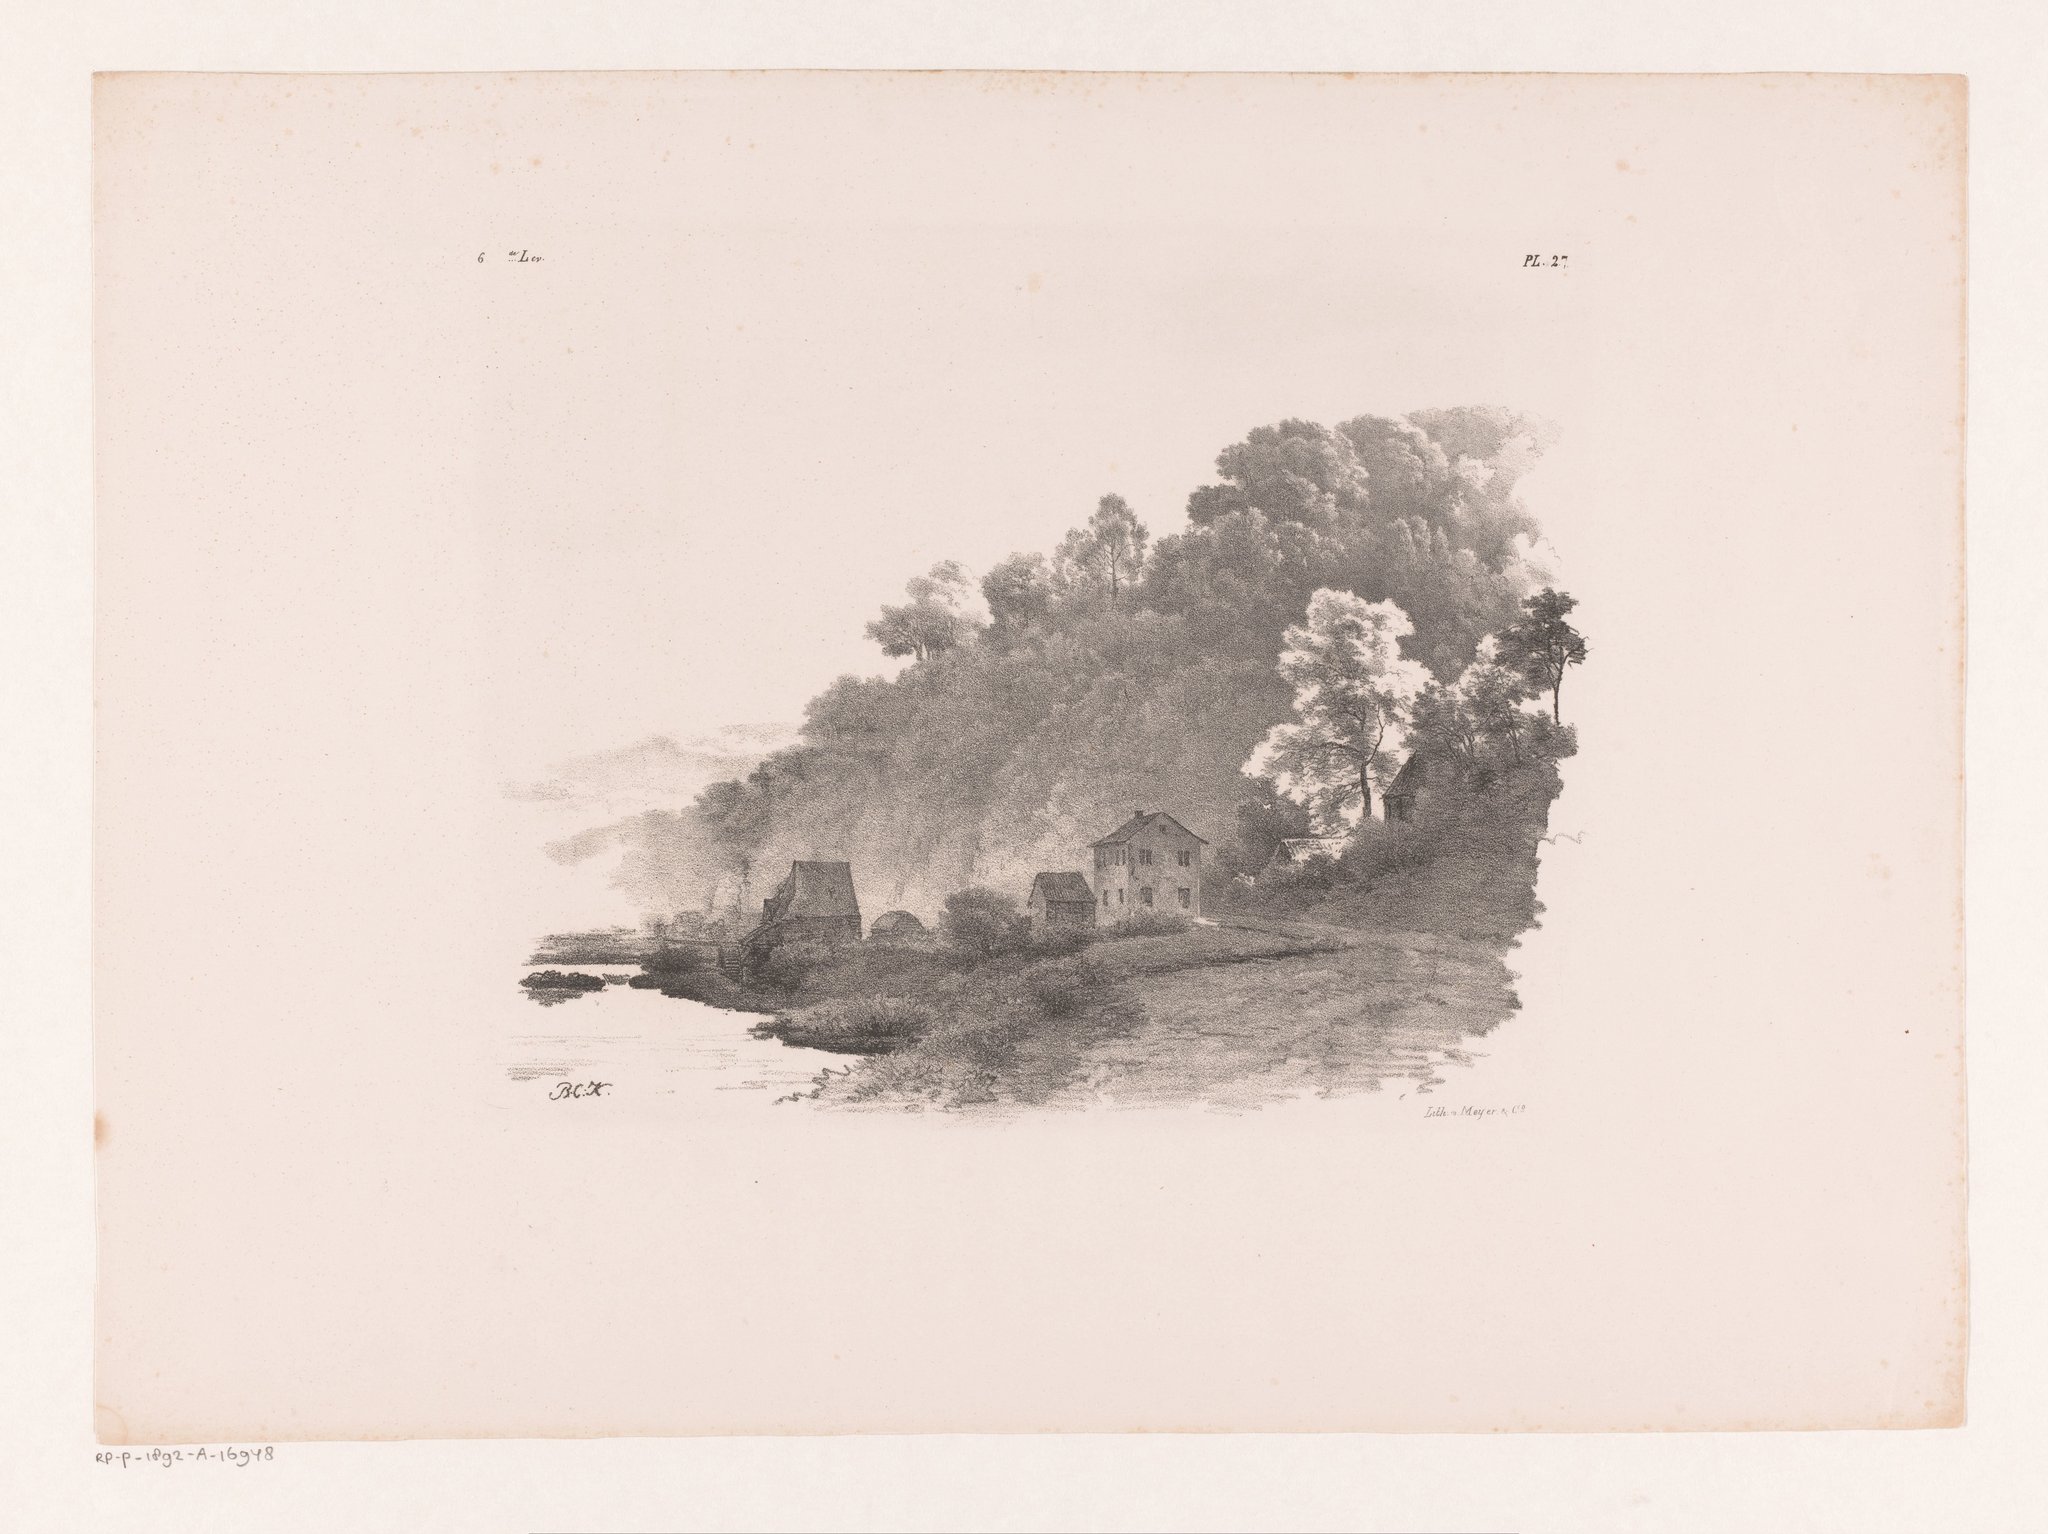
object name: print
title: Heuvellandschap met rivier, landweg en huizen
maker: barend cornelis koekkoek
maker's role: draughtsman, painter, print maker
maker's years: 1803-1862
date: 1844-1845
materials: paper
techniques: lithograph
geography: amsterdam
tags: low hill country, river, watermill in landscape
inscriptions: collector's mark: Lugt 2228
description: In 1829 en 1830 gaf Koekkoek, samen met Daiwaille, zes cahiers uit met ieder zes prenten getiteld Landschapstudiën. Deze werden gebruikt in het tekenonderwijs. Vijftien jaar later werd deze reeks, in een andere samenstelling nogmaals uitgegeven door Meyer en Comp in Amsterdam. Zie: De Bruyn Kops, 1963.